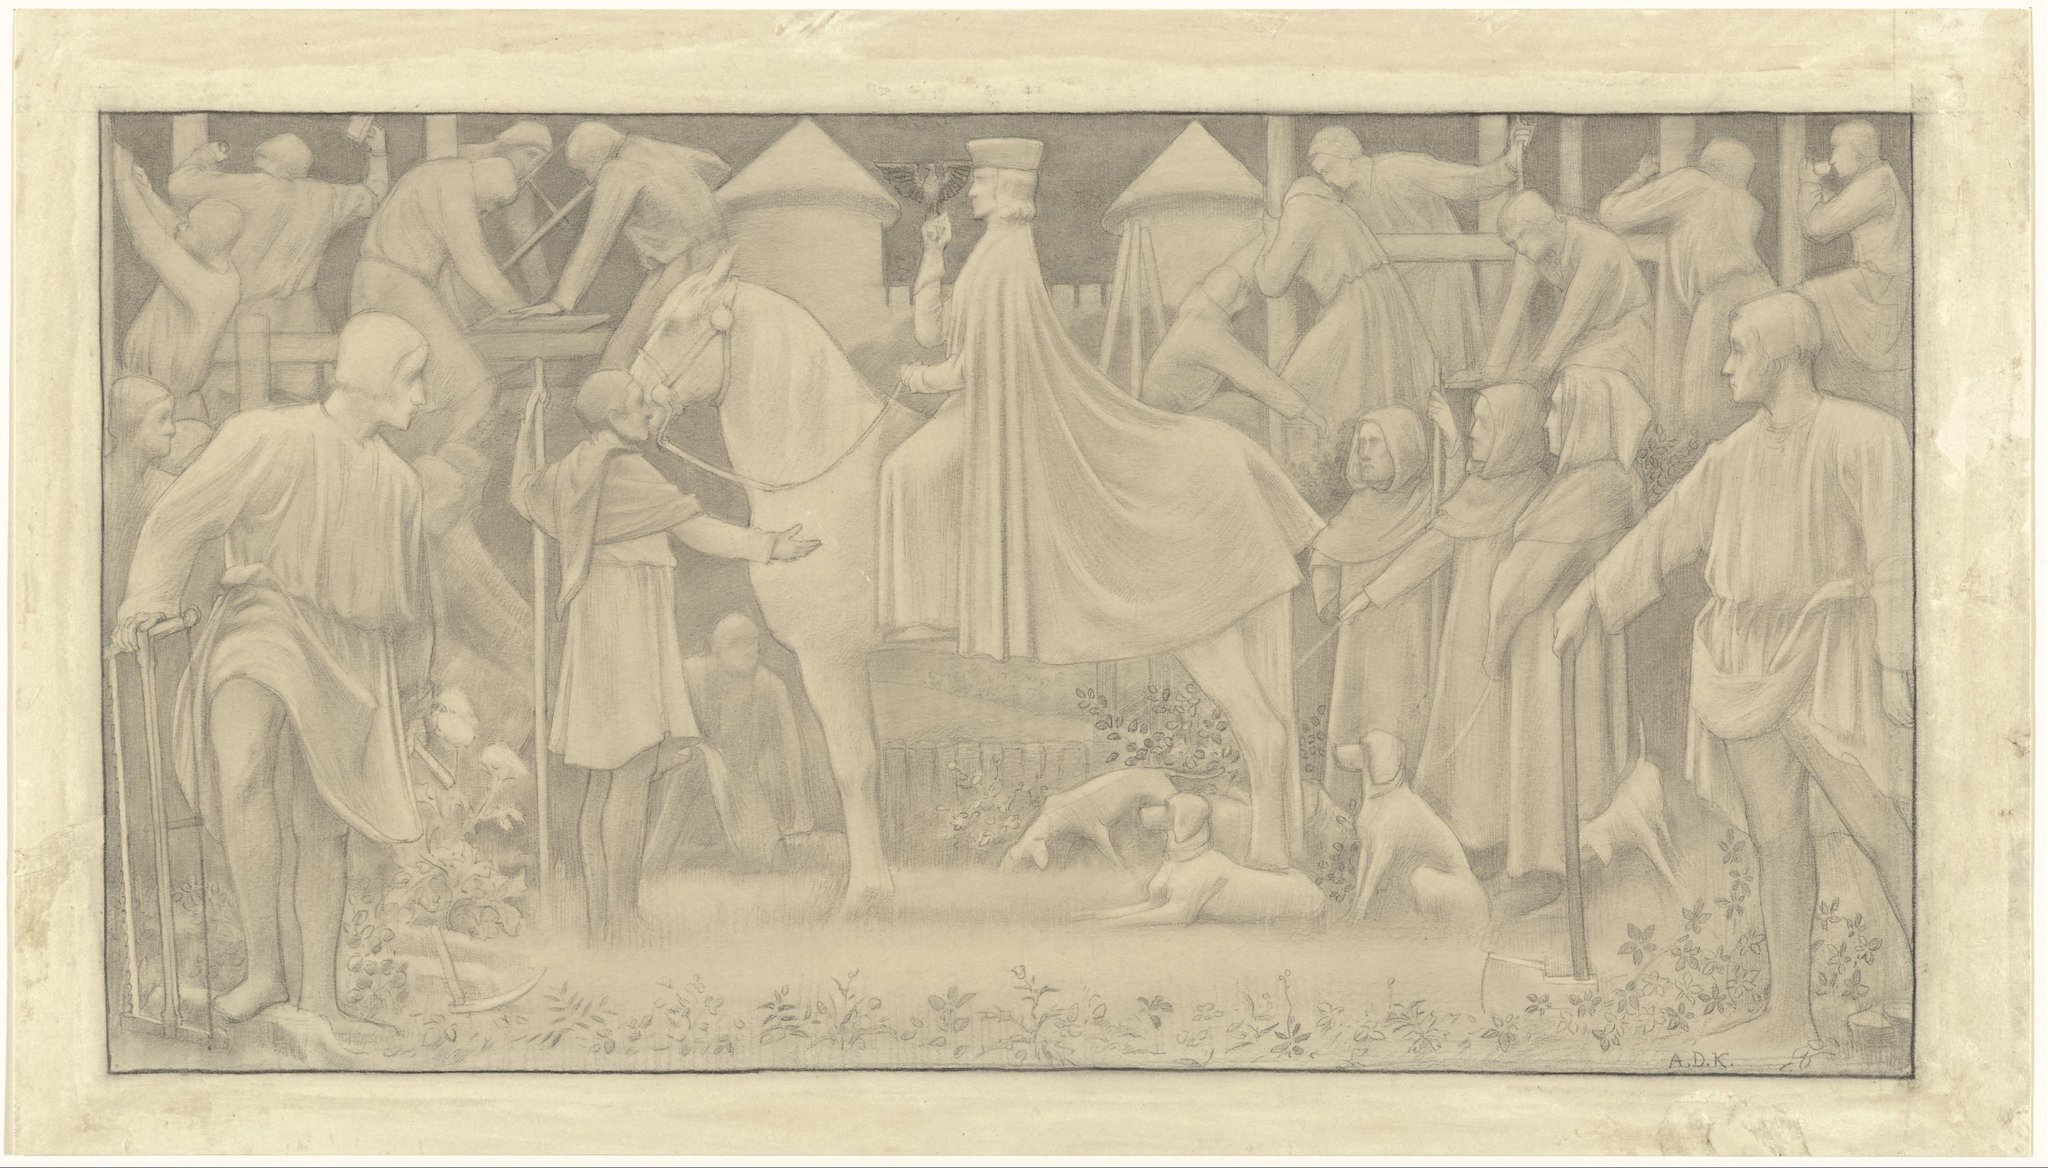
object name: design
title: Ontwerp voor de Eerste Bossche Wand: stichting van 's-Hertogenbosch door Hertog Hendrik van Brabant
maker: antoon derkinderen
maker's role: draughtsman, painter, print maker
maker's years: 1859-1925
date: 1869-1925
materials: chalk, paper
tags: city founders, historical persons, den bosch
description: Ontwerp voor een wandschildering in het stadhuis.